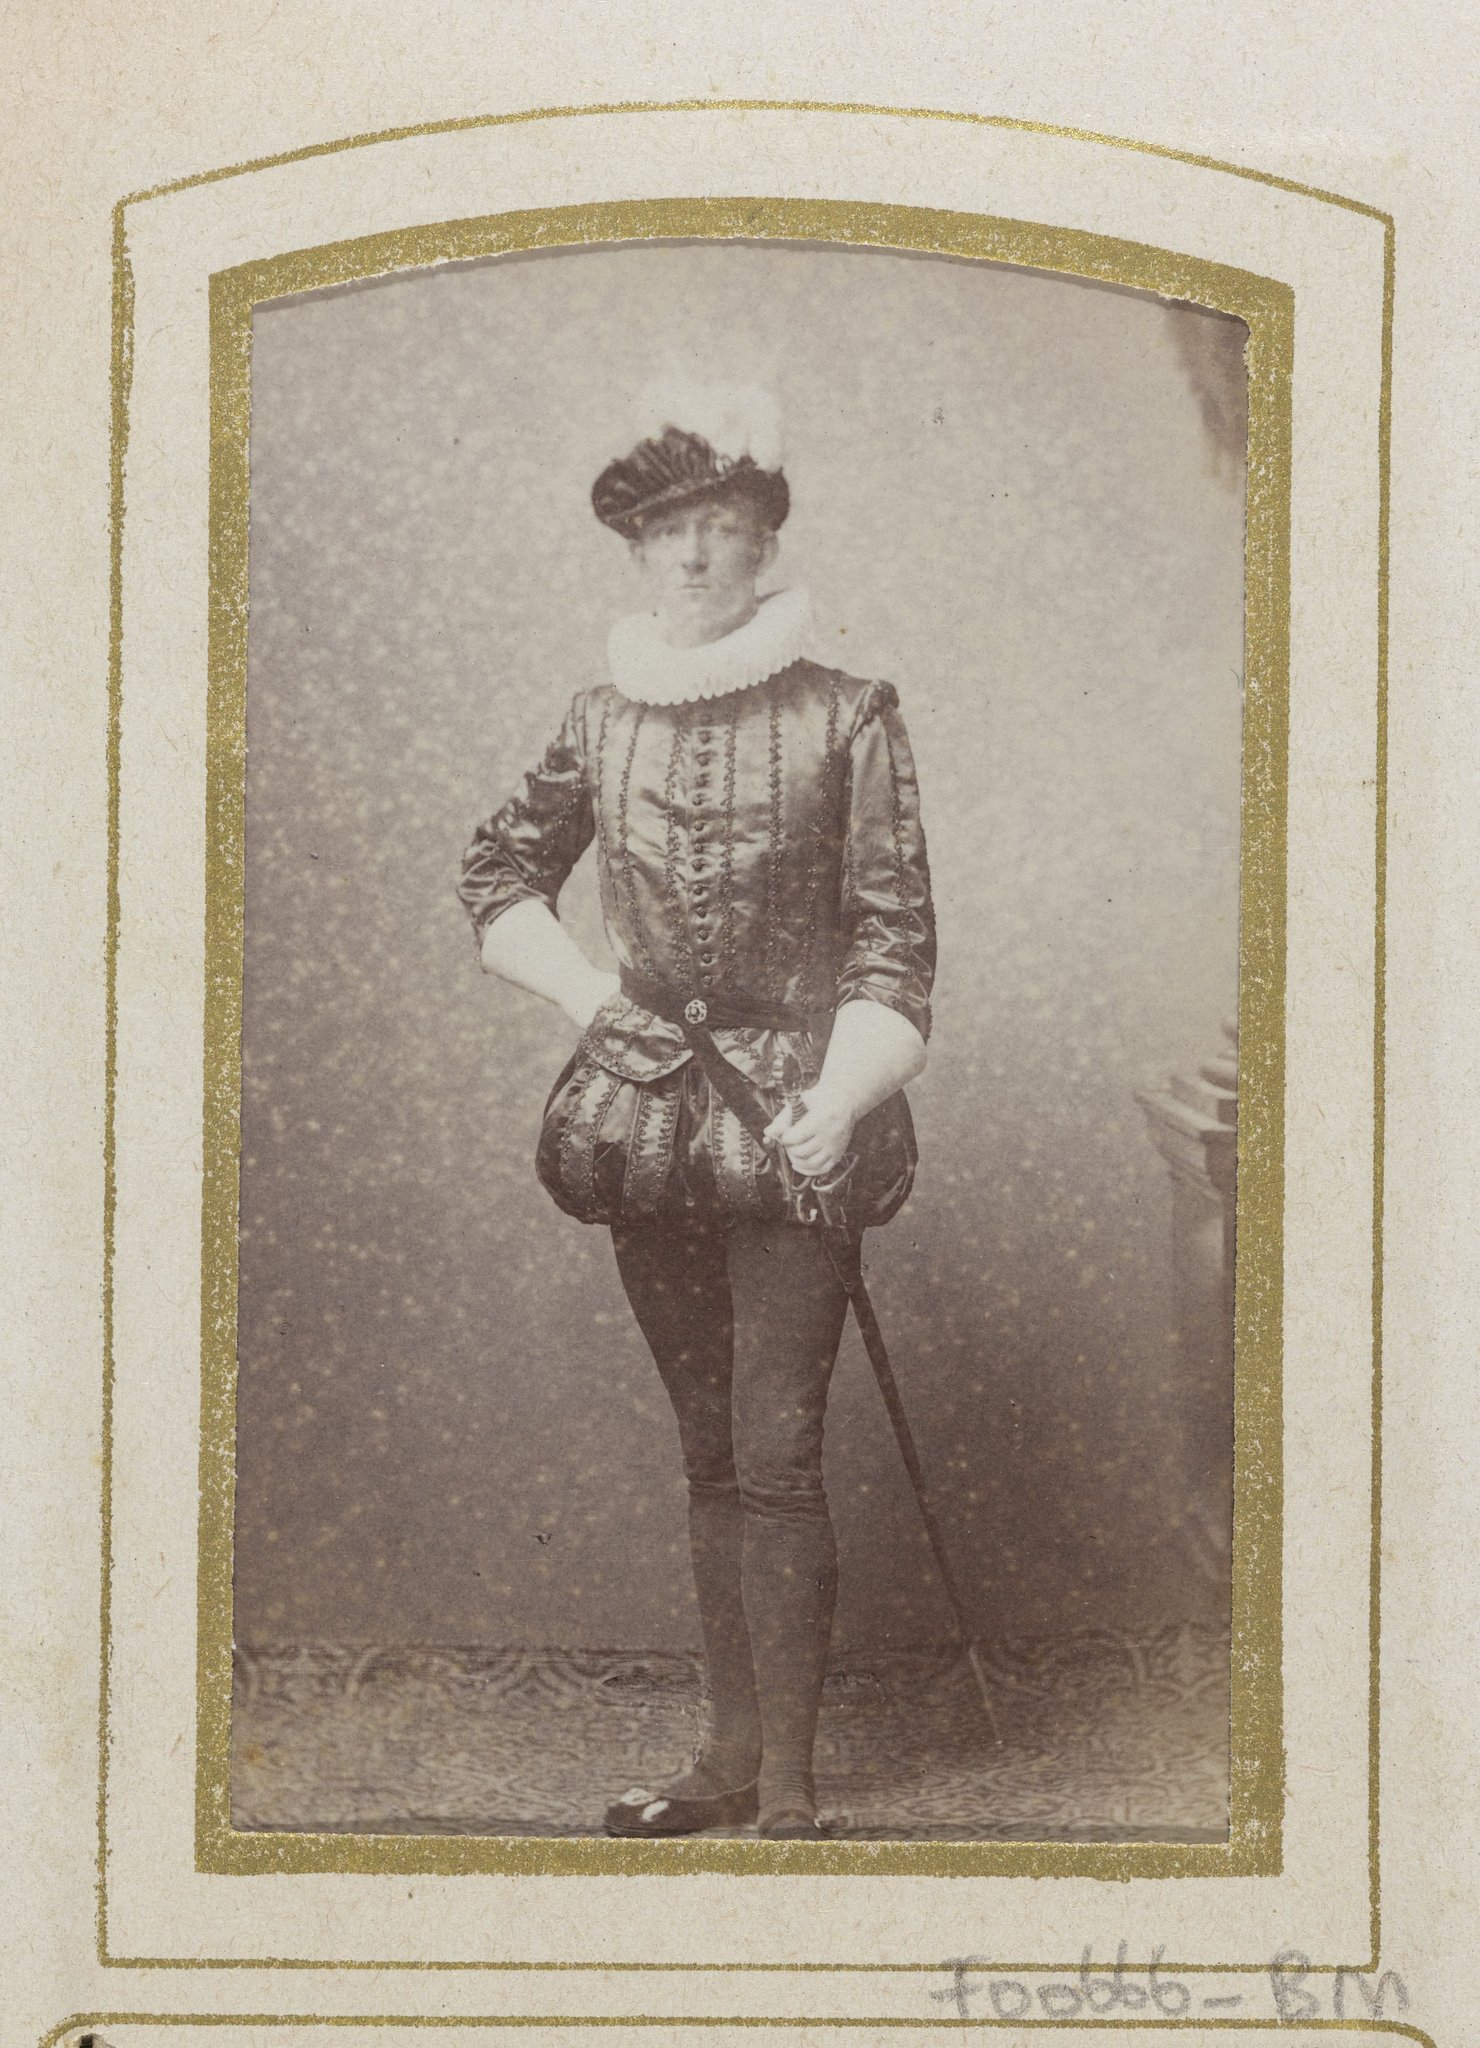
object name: carte de visite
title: Portret van een jonge man in kostuum met degen, aangeduid als C.A. Bergsma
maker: jan goedeljee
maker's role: fotograaf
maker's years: 1824-1905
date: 1860-1905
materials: cardboard, photographic support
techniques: albumen print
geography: leiden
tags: historical persons, historical costume, hacking and thrusting weapons: rapier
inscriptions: inscription: ‘J. Goedeljee/ Photograaf/ Z. K. H. PRINS ALEXANDER/ der Nederlanden/ PRINS van ORANJE/ en H. K. H./ PRINSES HENDRIK/ der Nederlanden/ Hoogewoerd 160/ nabij de Plantage.’, name: ‘C. A. Bergsma./ 99.’